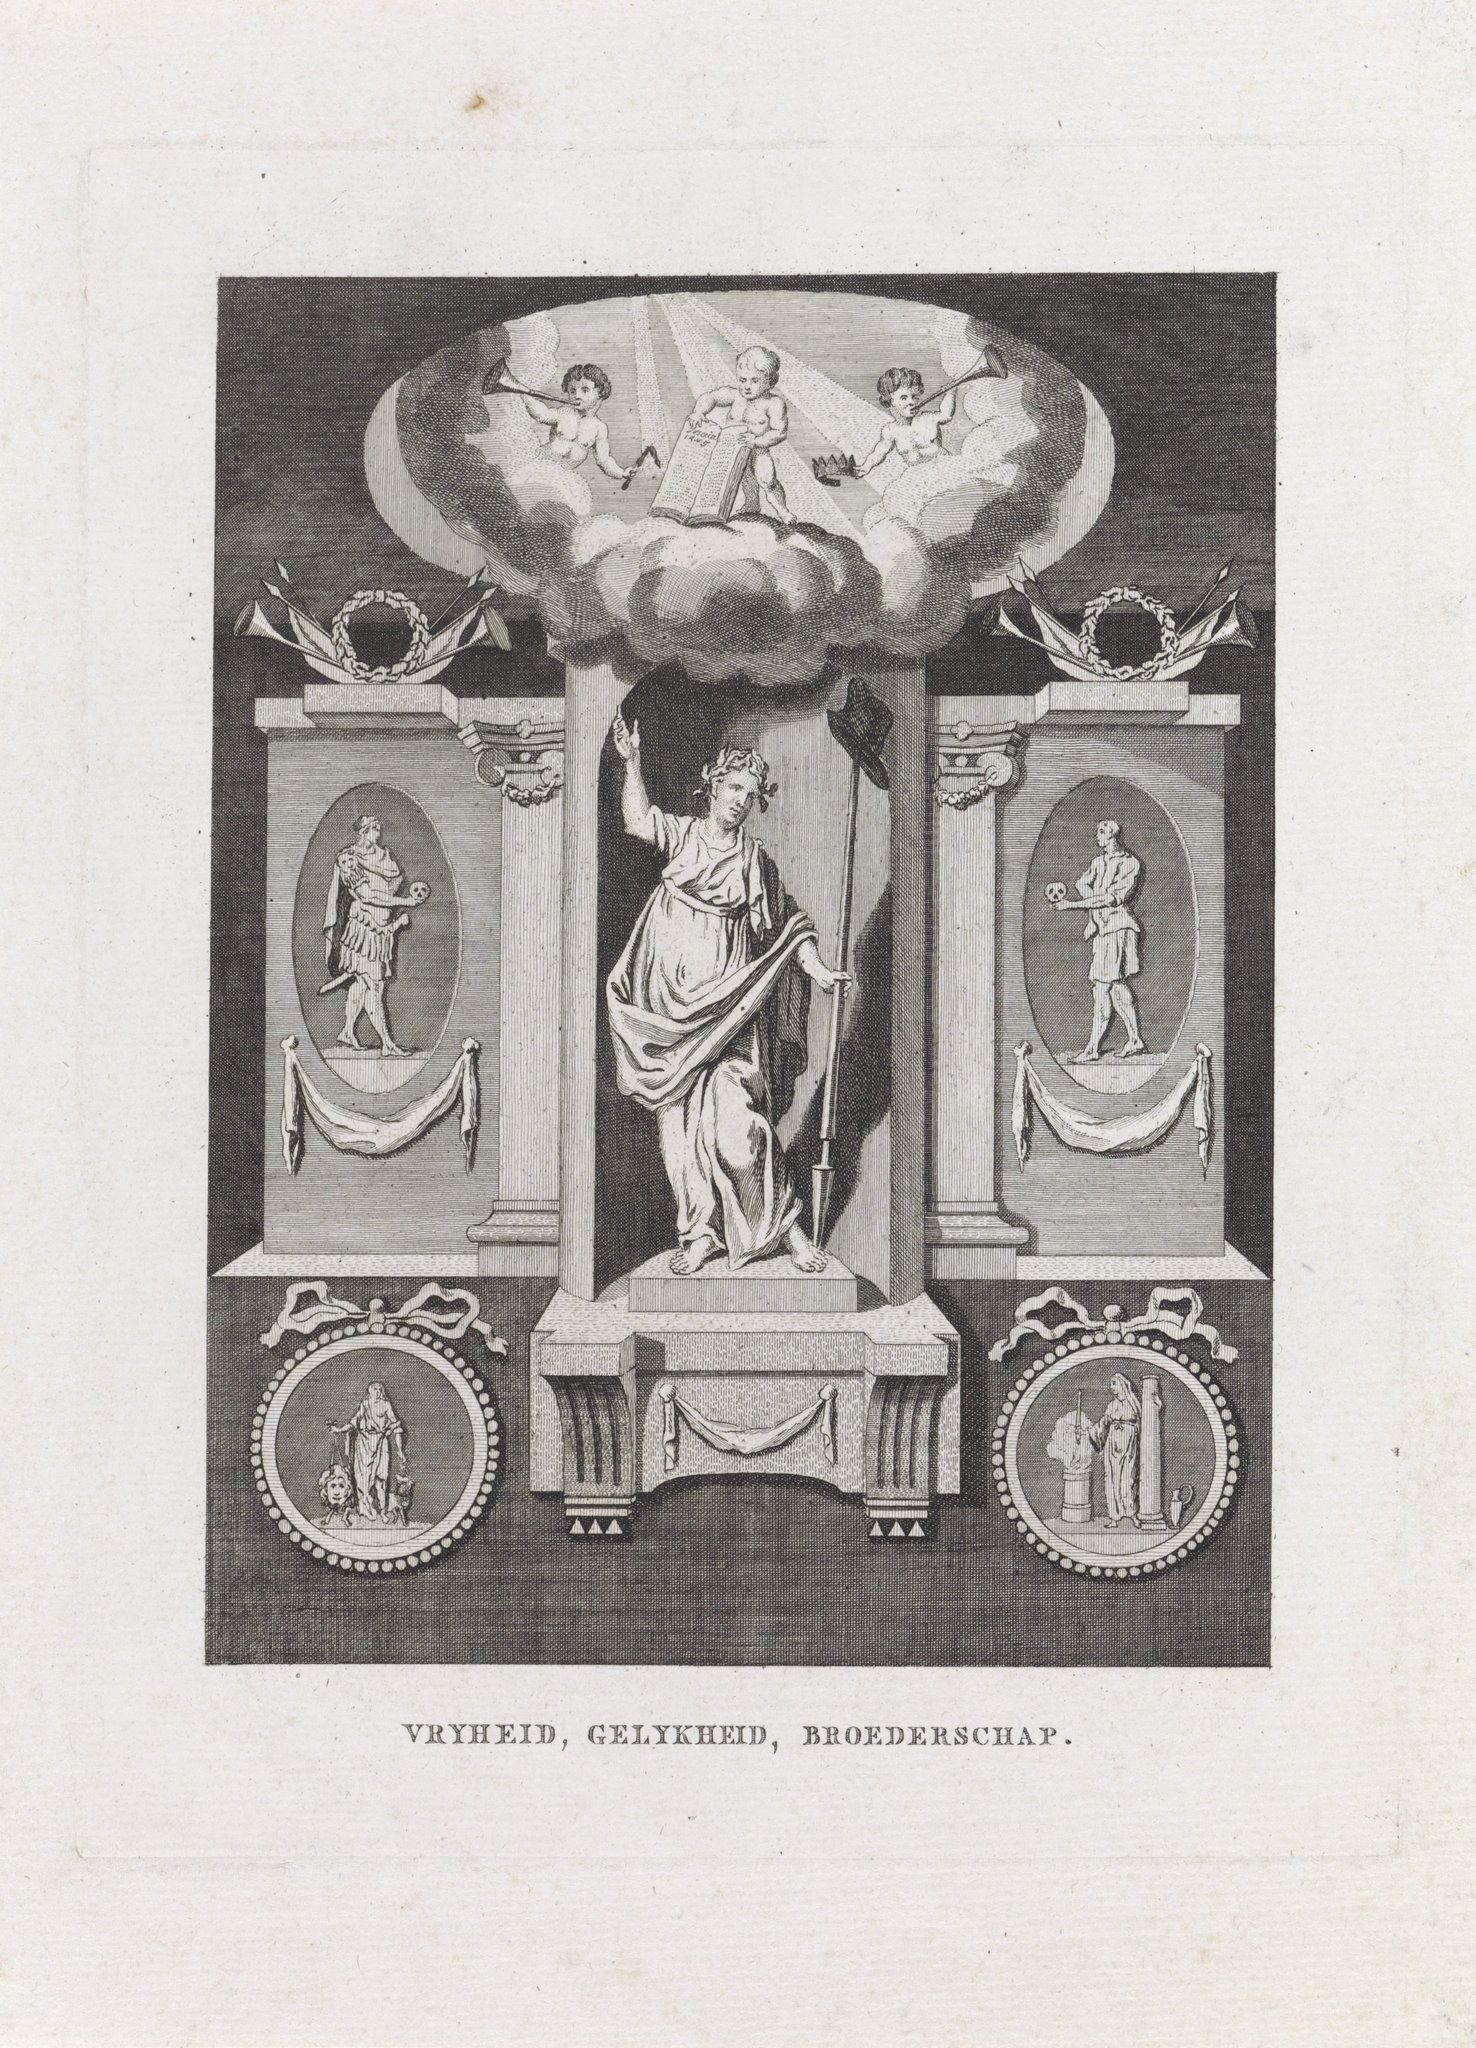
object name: print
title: Allegorie op de Vrijheid, Gelijkheid en Broederschap, 1795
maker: Anonymous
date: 1795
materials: paper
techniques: engraving, etching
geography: netherlands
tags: the book of isaiah, freedom, liberty; 'libertà' (ripa) (+ abstract concept represented by female figure)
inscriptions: collector's mark: Lugt 2228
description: Allegorie op de Vrijheid, Gelijkheid en Broederschap, 1795. Centraal nis met standbeeld van de Vrijheid, links en rechts staande figuren met doodskoppen, onderaan twee andere allegorische medaillons met strikken. Bovenaan putti in de hemel met bijbelboek Jesaja.